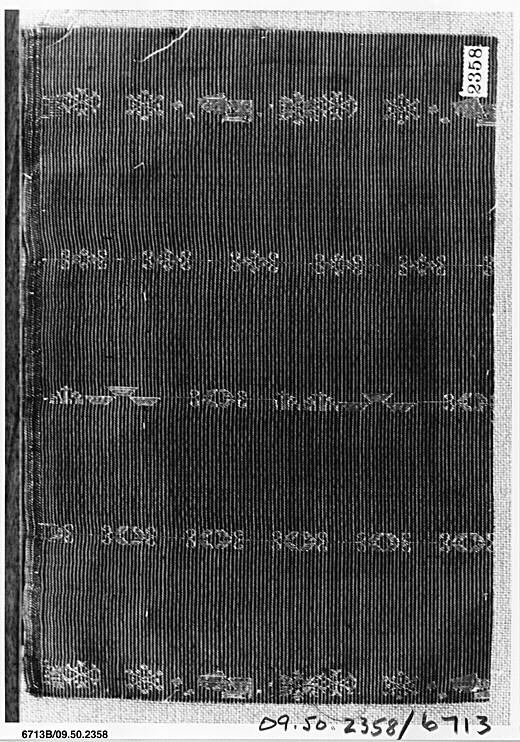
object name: piece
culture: japanese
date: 1615-1868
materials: metal thread, silk